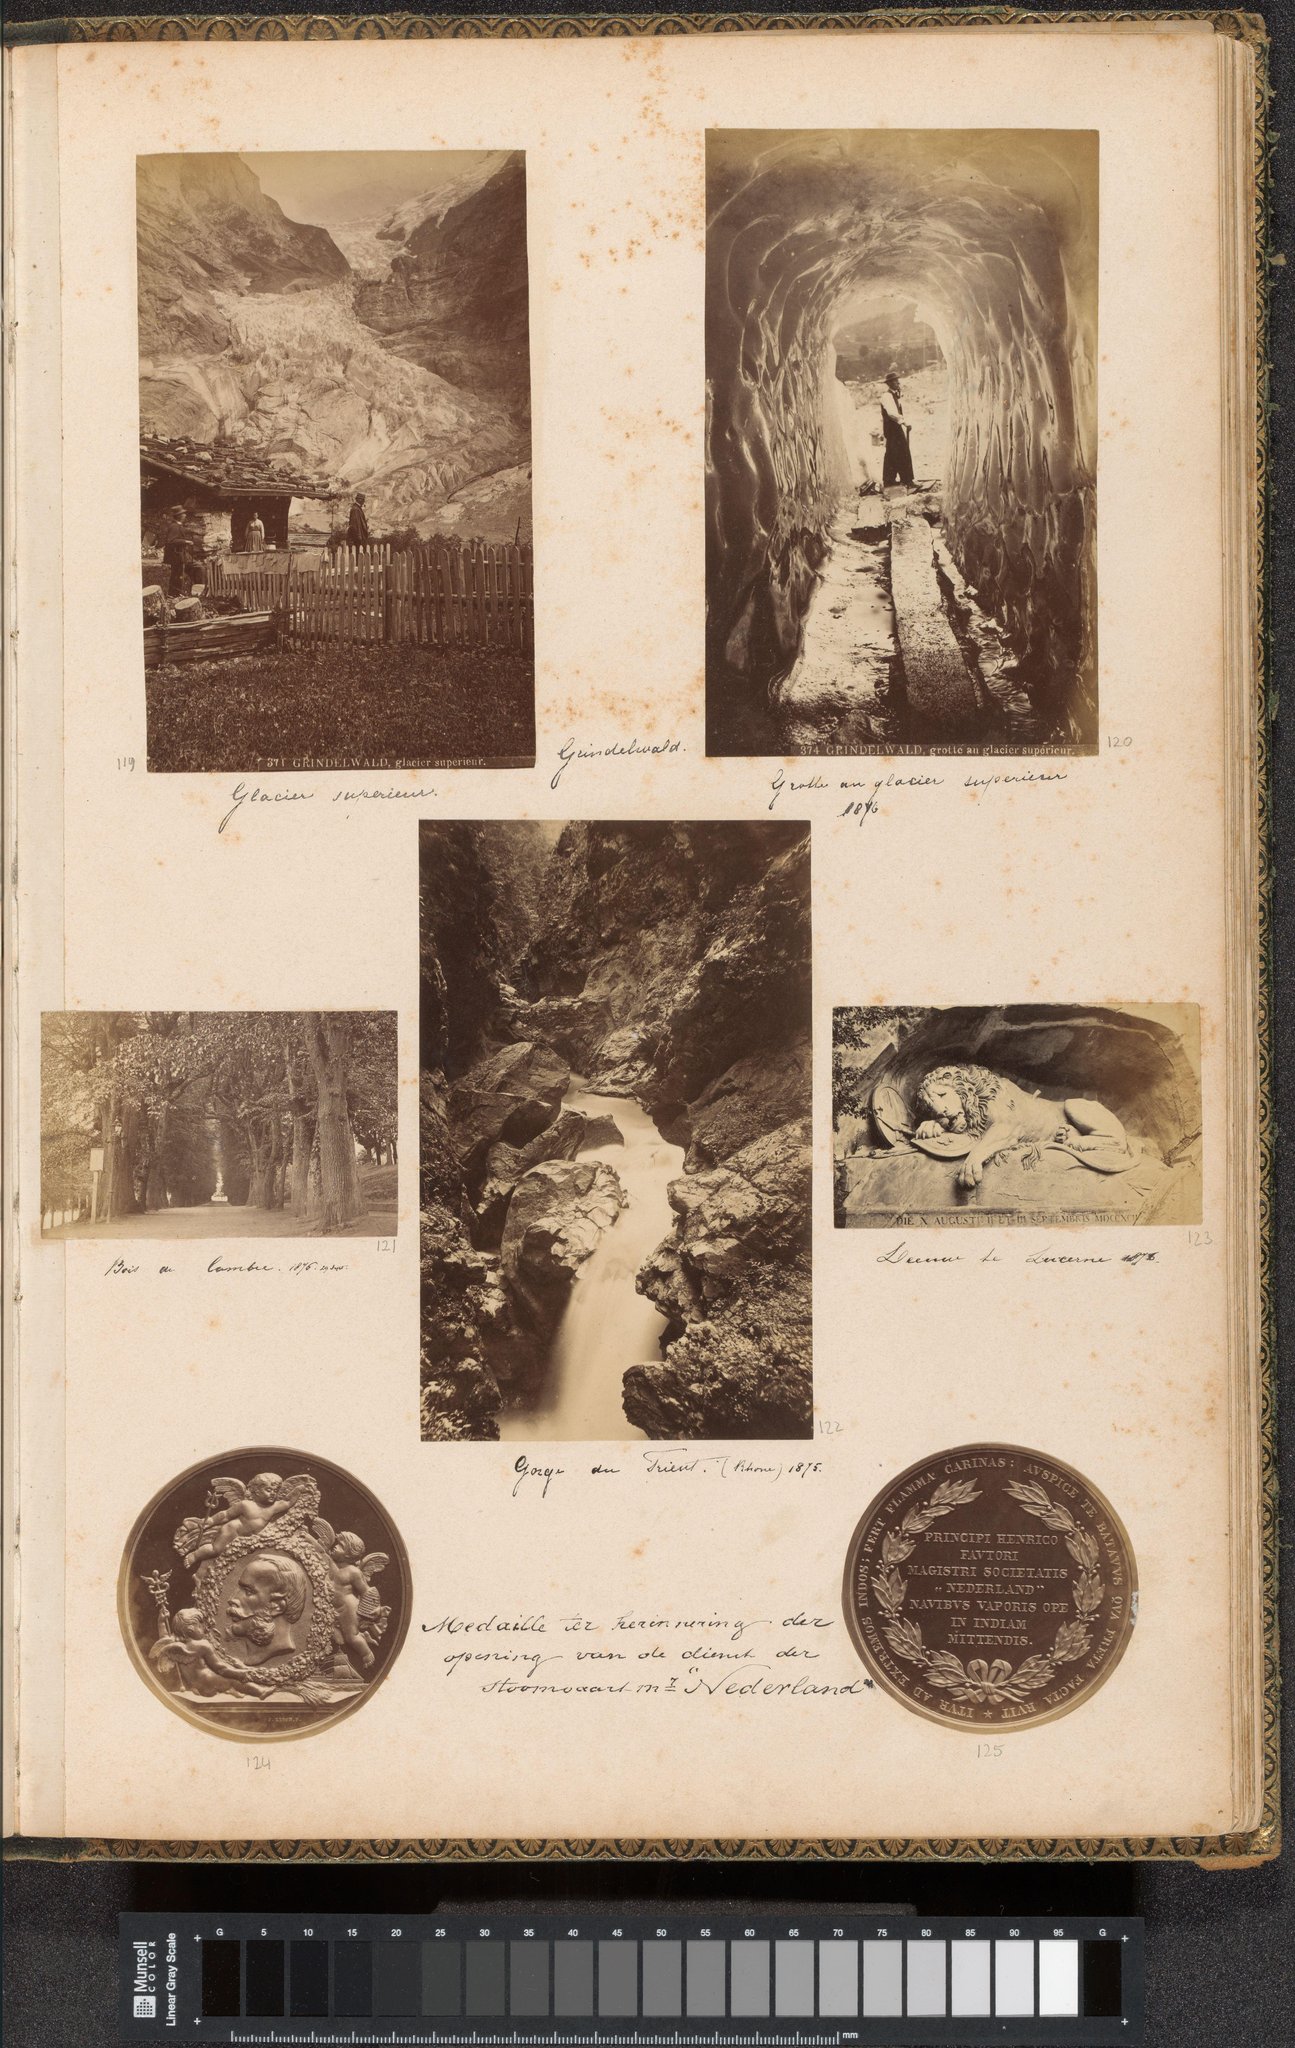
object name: album leaf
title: Laan in het Ter Kamerenbos (Bois de la Cambre) te Brussel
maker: Anonymous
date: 1876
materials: paper, photographic support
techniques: albumen print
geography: brussels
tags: forest, wood, forest path or lane, brussels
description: Onderdeel van Fotoalbum van Robert Daniel Crommelin (1841-1907).